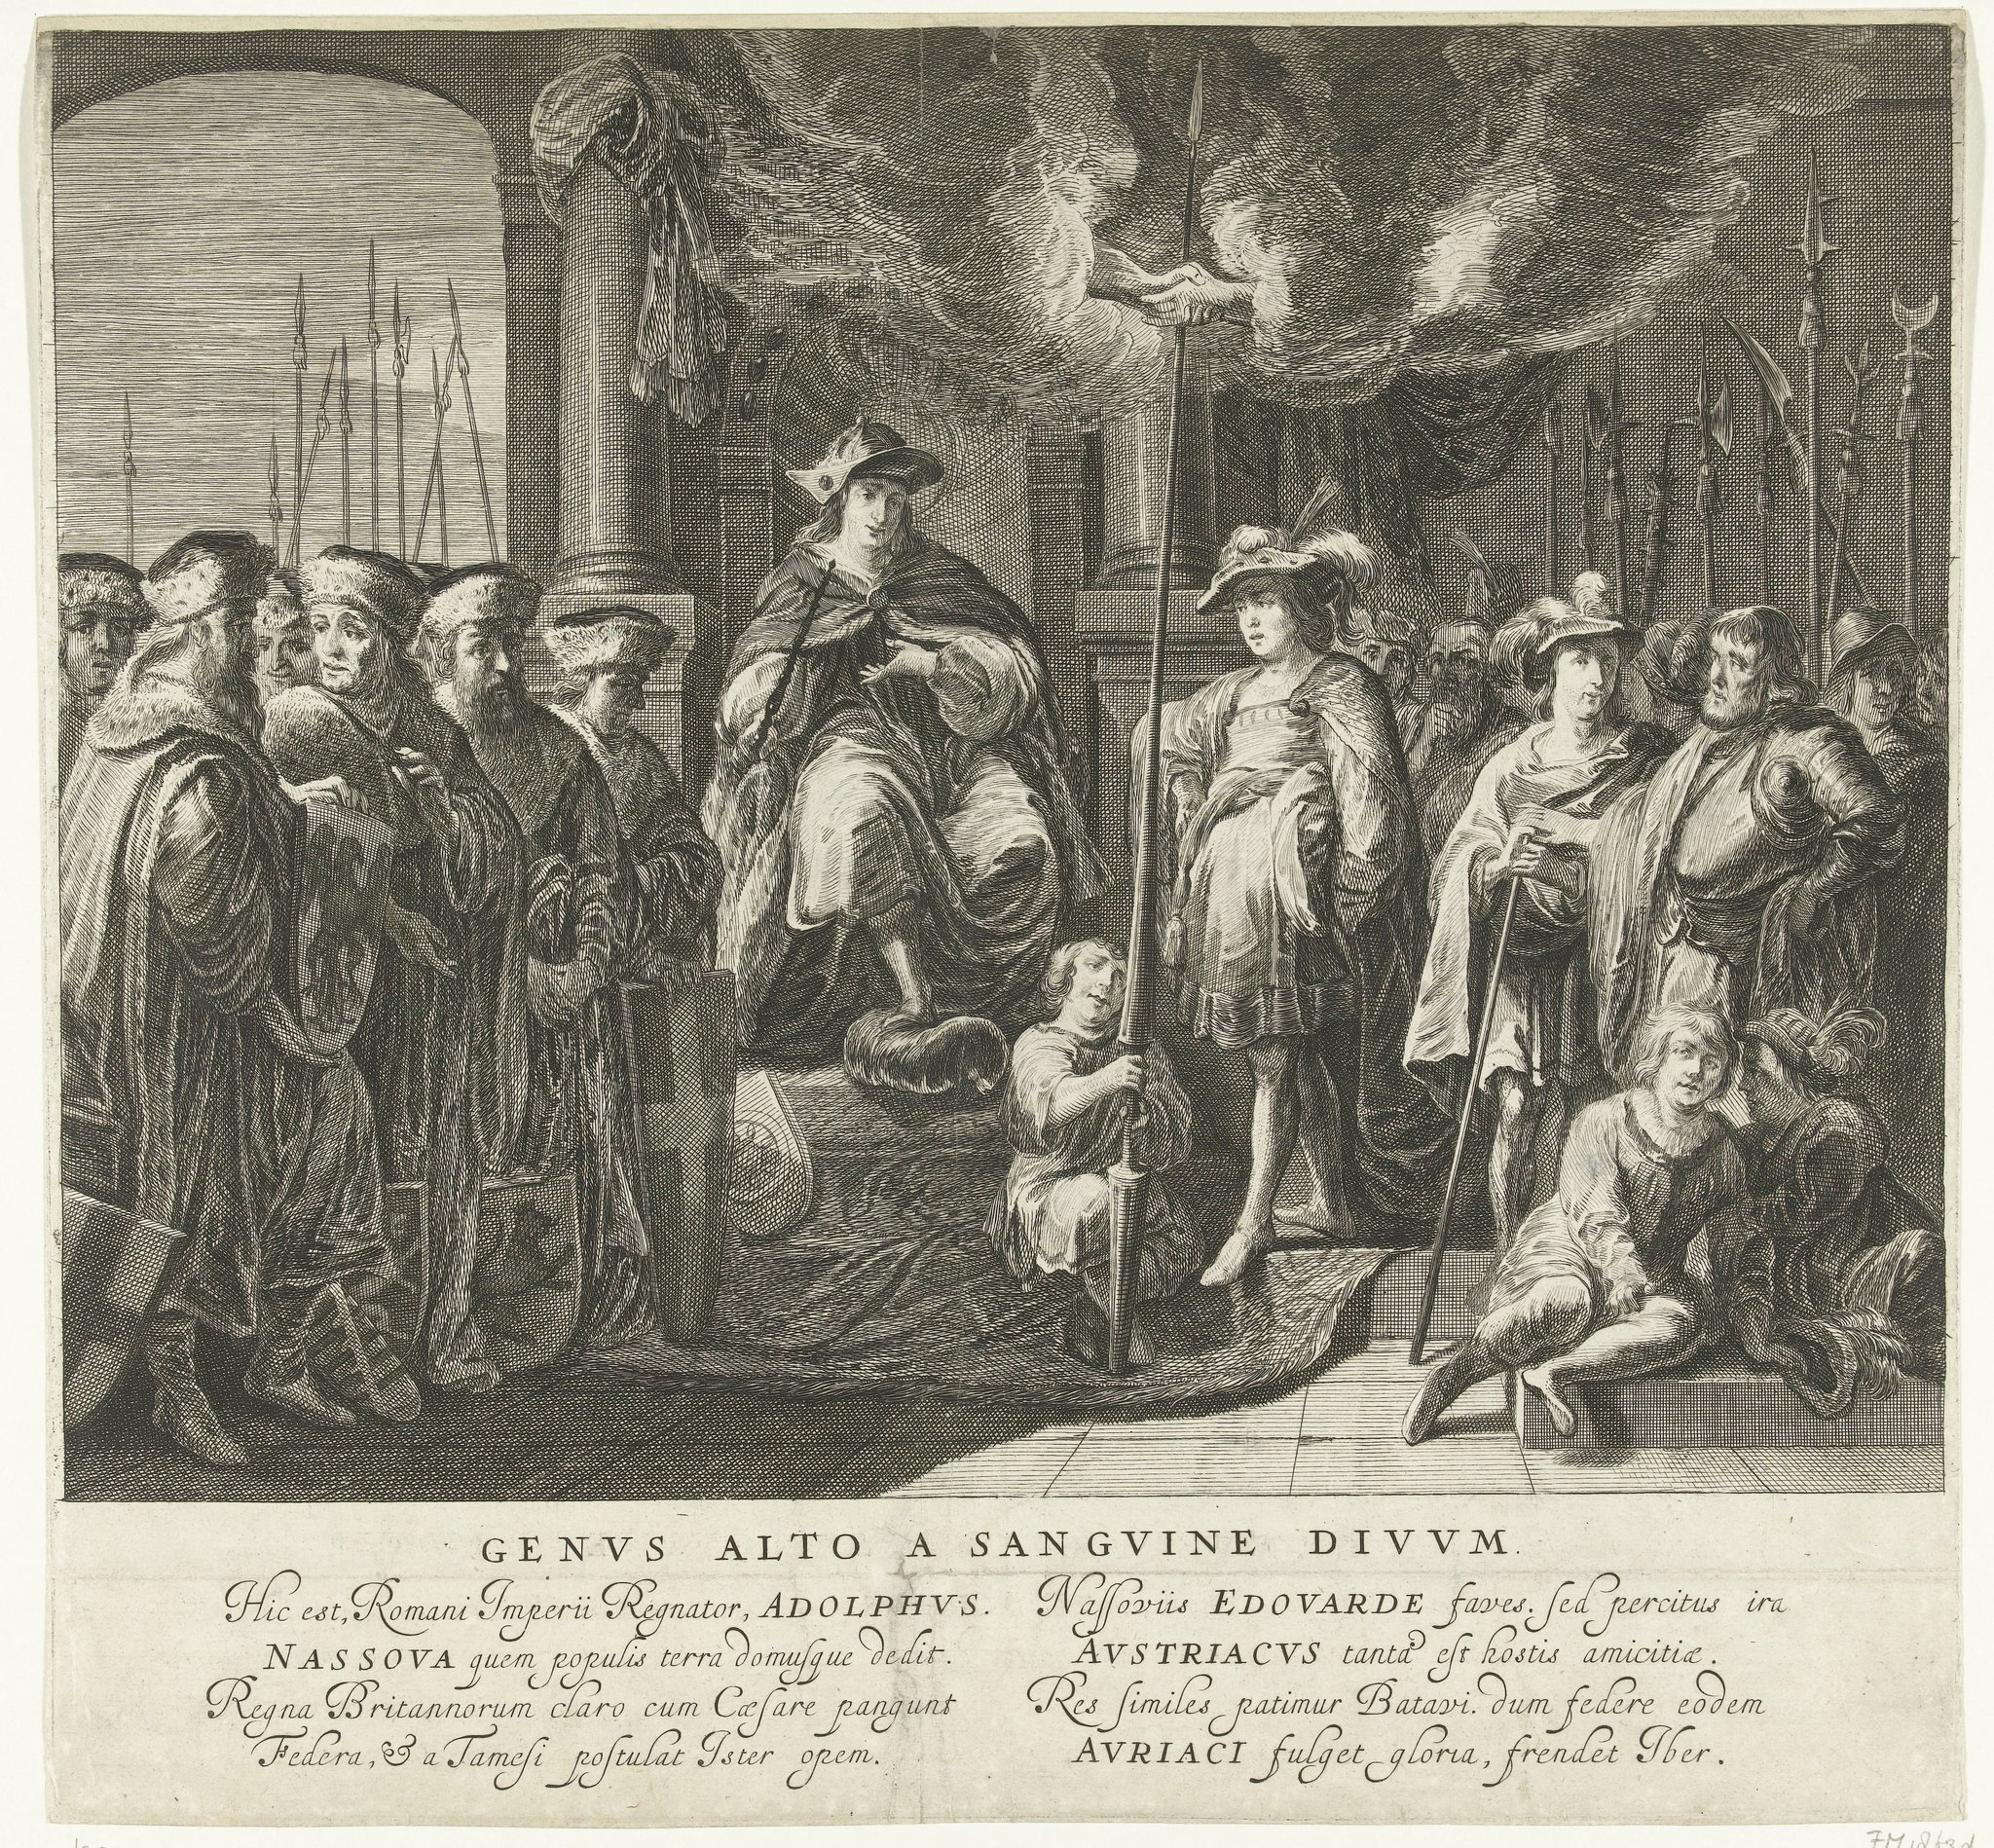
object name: print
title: Tableau vivant met het verbond tussen koning Adolf van Nassau en de Engelse koning Eduard I in 1294, 1642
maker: pieter nolpe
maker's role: draughtsman, print maker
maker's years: 1613-1653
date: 1642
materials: paper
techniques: engraving, etching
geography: northern netherlands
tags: henriëtta maria van frankrijk (koningin van engeland, schotland en ierland), 'tableau vivant', triumphal entry and public reception, pageant, 'entrée solennelle', 'joyeuse entrée', alliance, league, union, foedus, amsterdam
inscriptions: collector's mark: Lugt 240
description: Allegorisch tableau vivant met het verbond tussen Rooms-Duits koning Adolf van Nassau en de Engelse koning Eduard I in 1294. Vertoning in de theaterpoort opgericht op de Dam voor de Beurssteeg bij het bezoek van Engelse koningin Henrietta Maria aan Amsterdam, 20-22 mei 1642. In het onderschrift de titel en 2 keer 4 regels in het Latijn. Vierde plaat in een groep van tien vertoningen en triomfbogen.